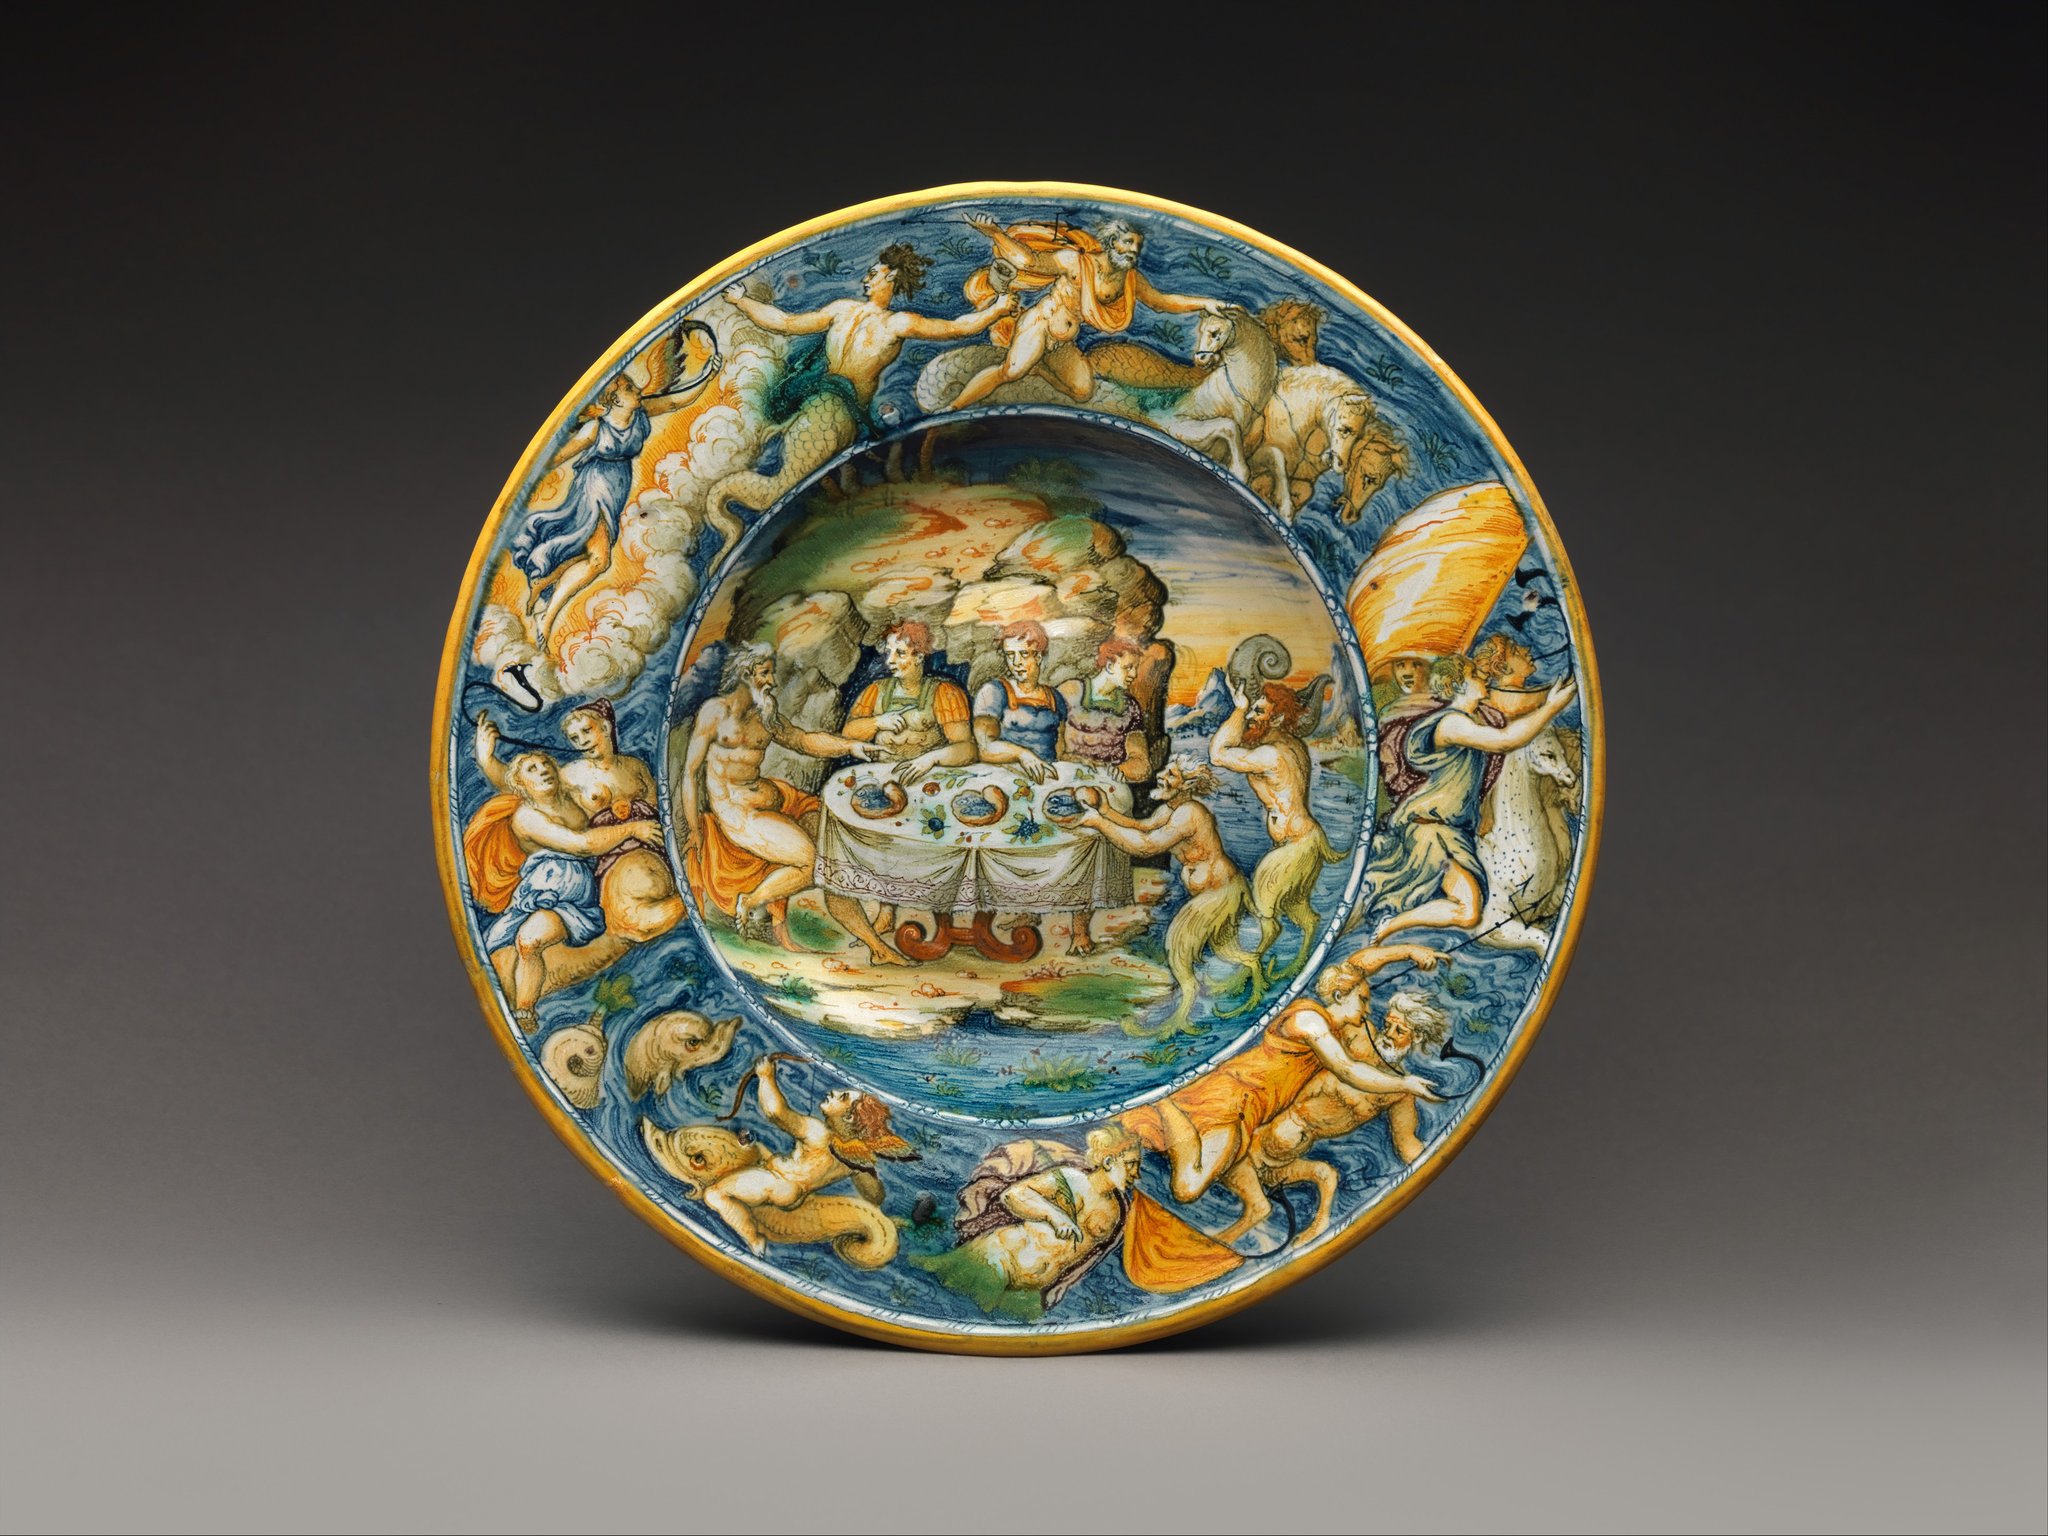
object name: dish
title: Dish Depicting Achelous and Theseus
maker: maestro domenego da venezia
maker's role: artist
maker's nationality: italian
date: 1550-1570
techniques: maiolica, glazing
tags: human figures,theseus,mermaids,horses